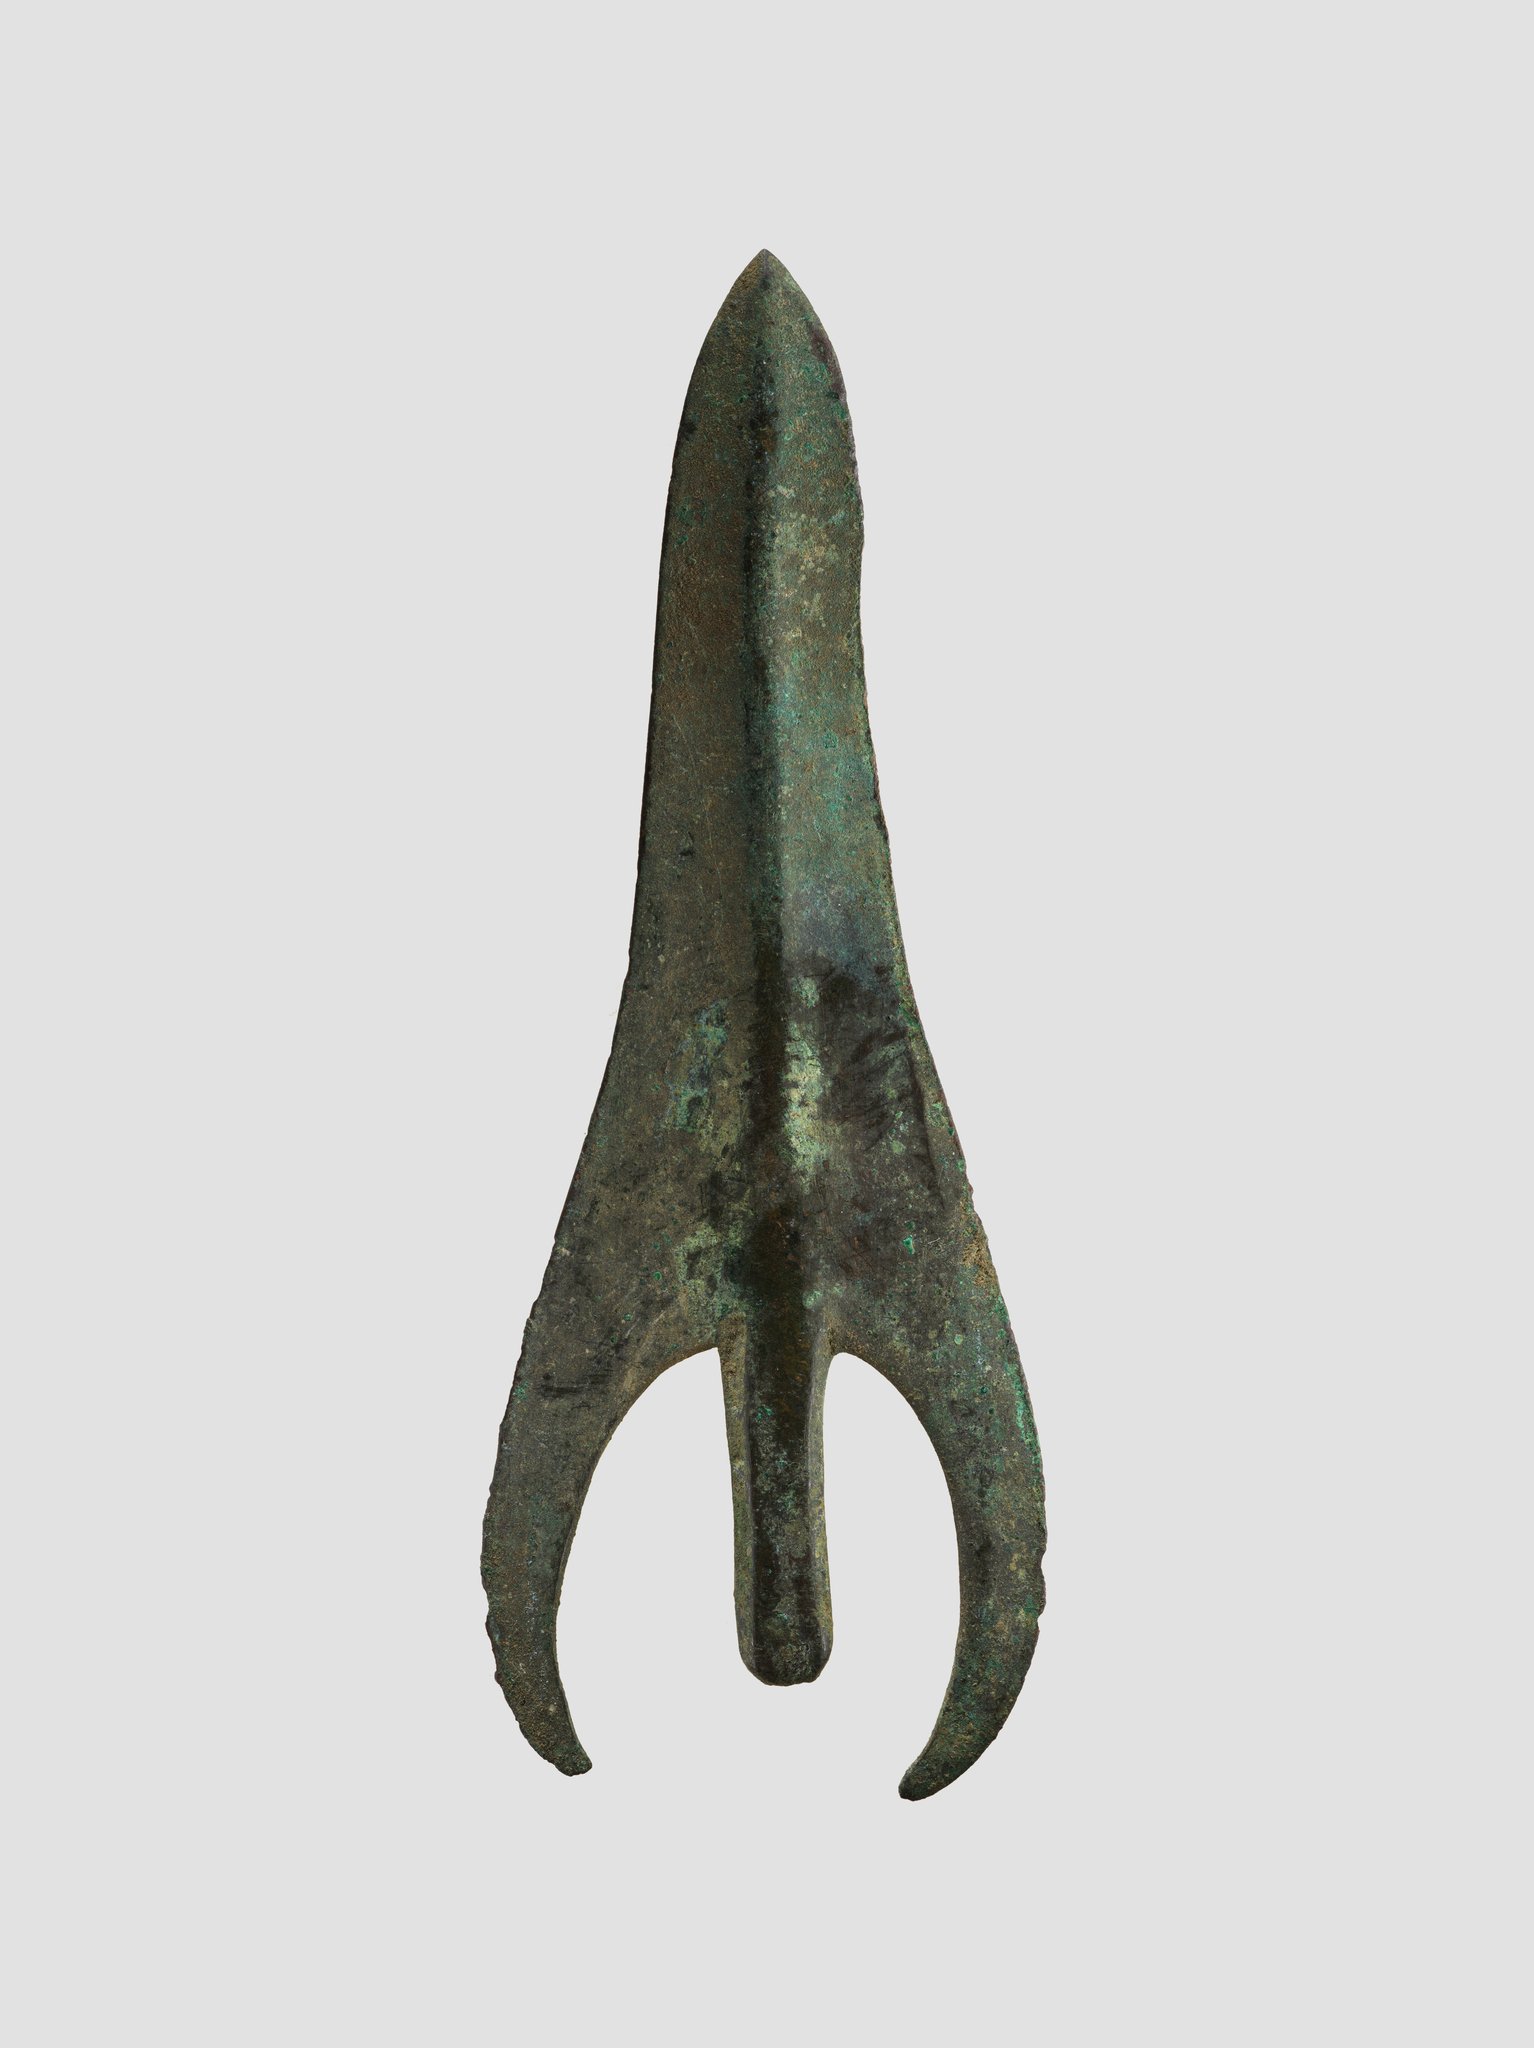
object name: arrowhead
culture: iranian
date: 2000-1 BCE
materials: bronze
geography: iran